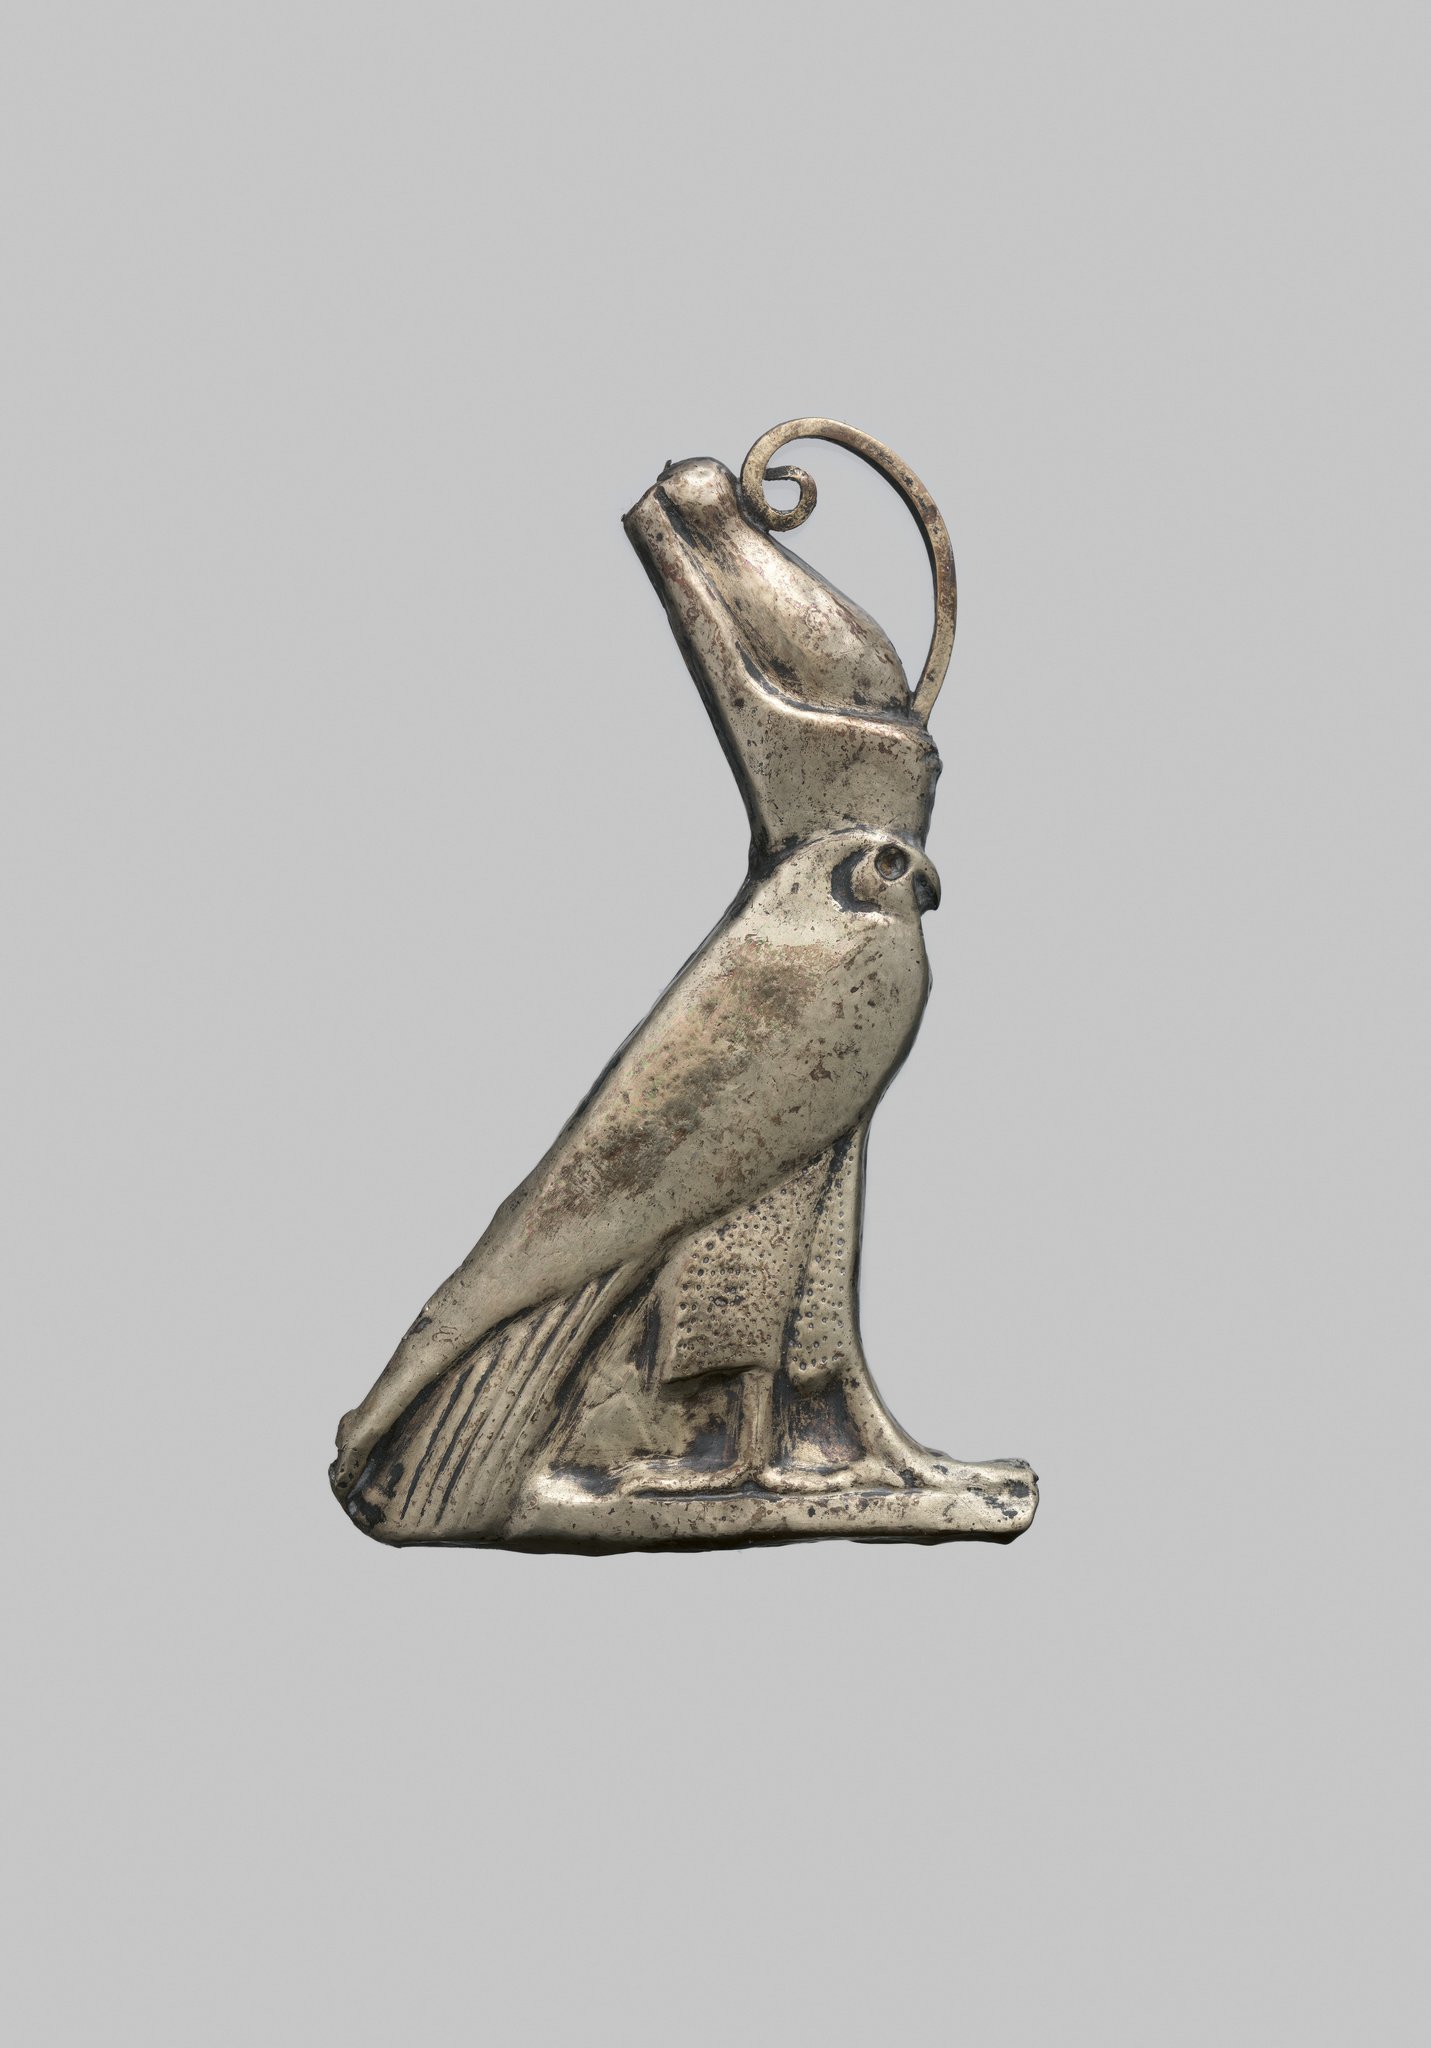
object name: pendant, falcon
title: Pendant of Horus wearing the double crown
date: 1850-1700 BCE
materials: plaster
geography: egypt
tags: falcons